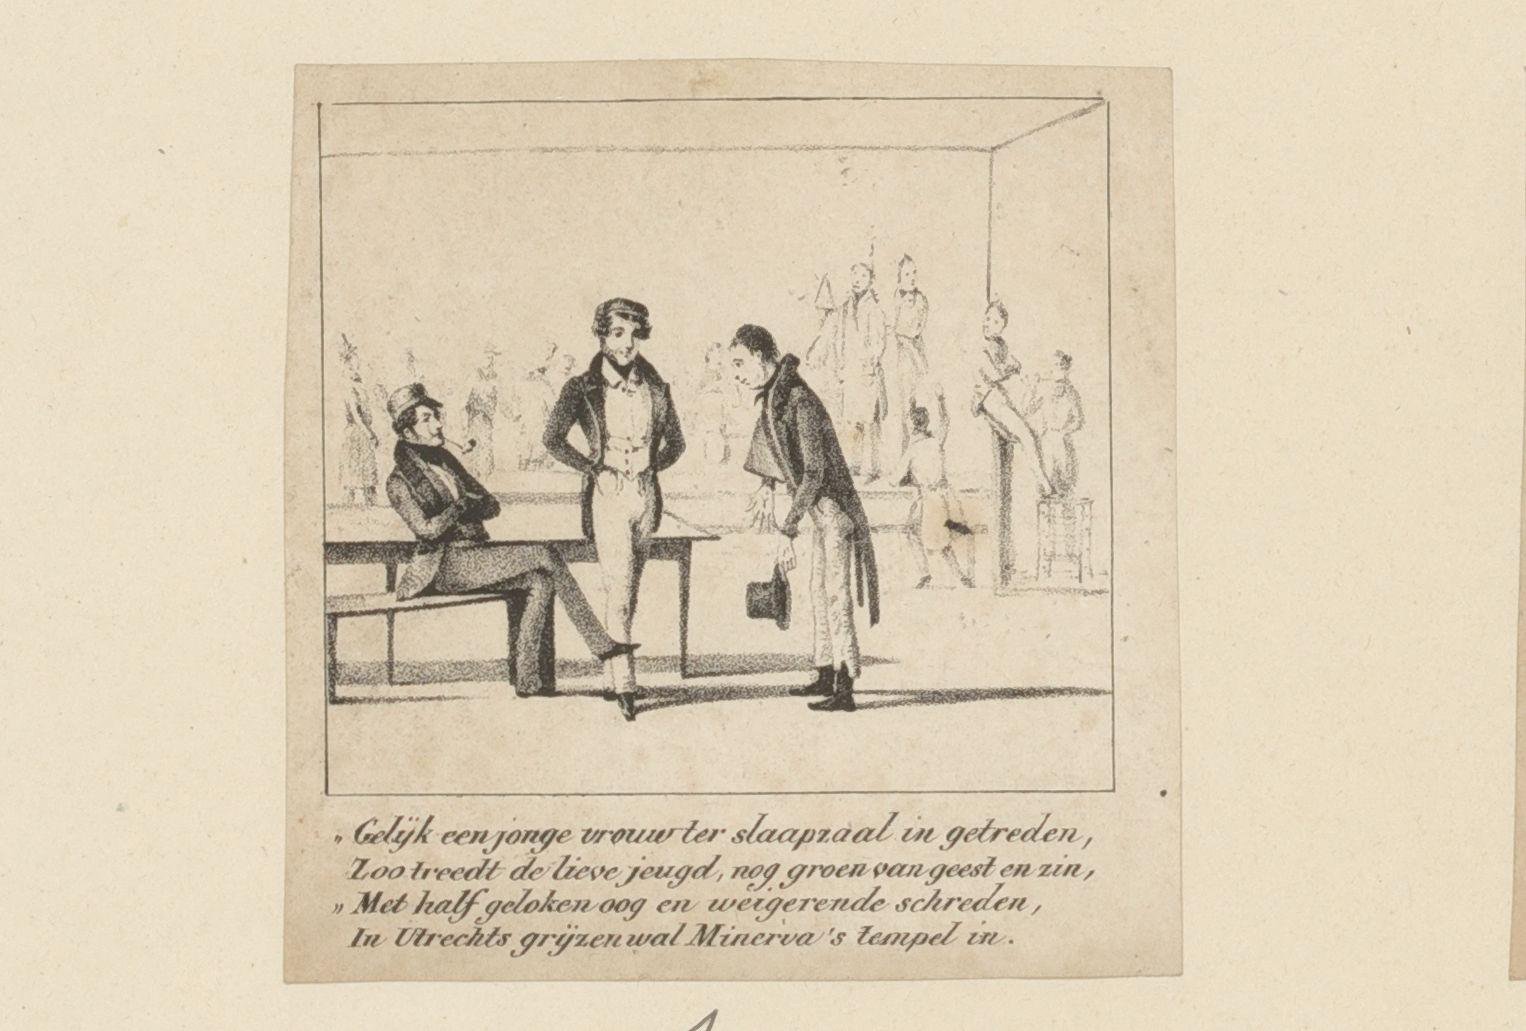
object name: print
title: Drie studenten in een zaal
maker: Anonymous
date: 1835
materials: paper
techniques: lithograph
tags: student life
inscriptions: stamp, stamp, collector's mark: Lugt 1641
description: Prent mogelijk geknipt uit een grotere prent met de titel op object: Stichtsche School-prent. Prent gepubliceerd bij: Utrechtsche Studenten almanak. Utrecht: J. van Druten, 1885.